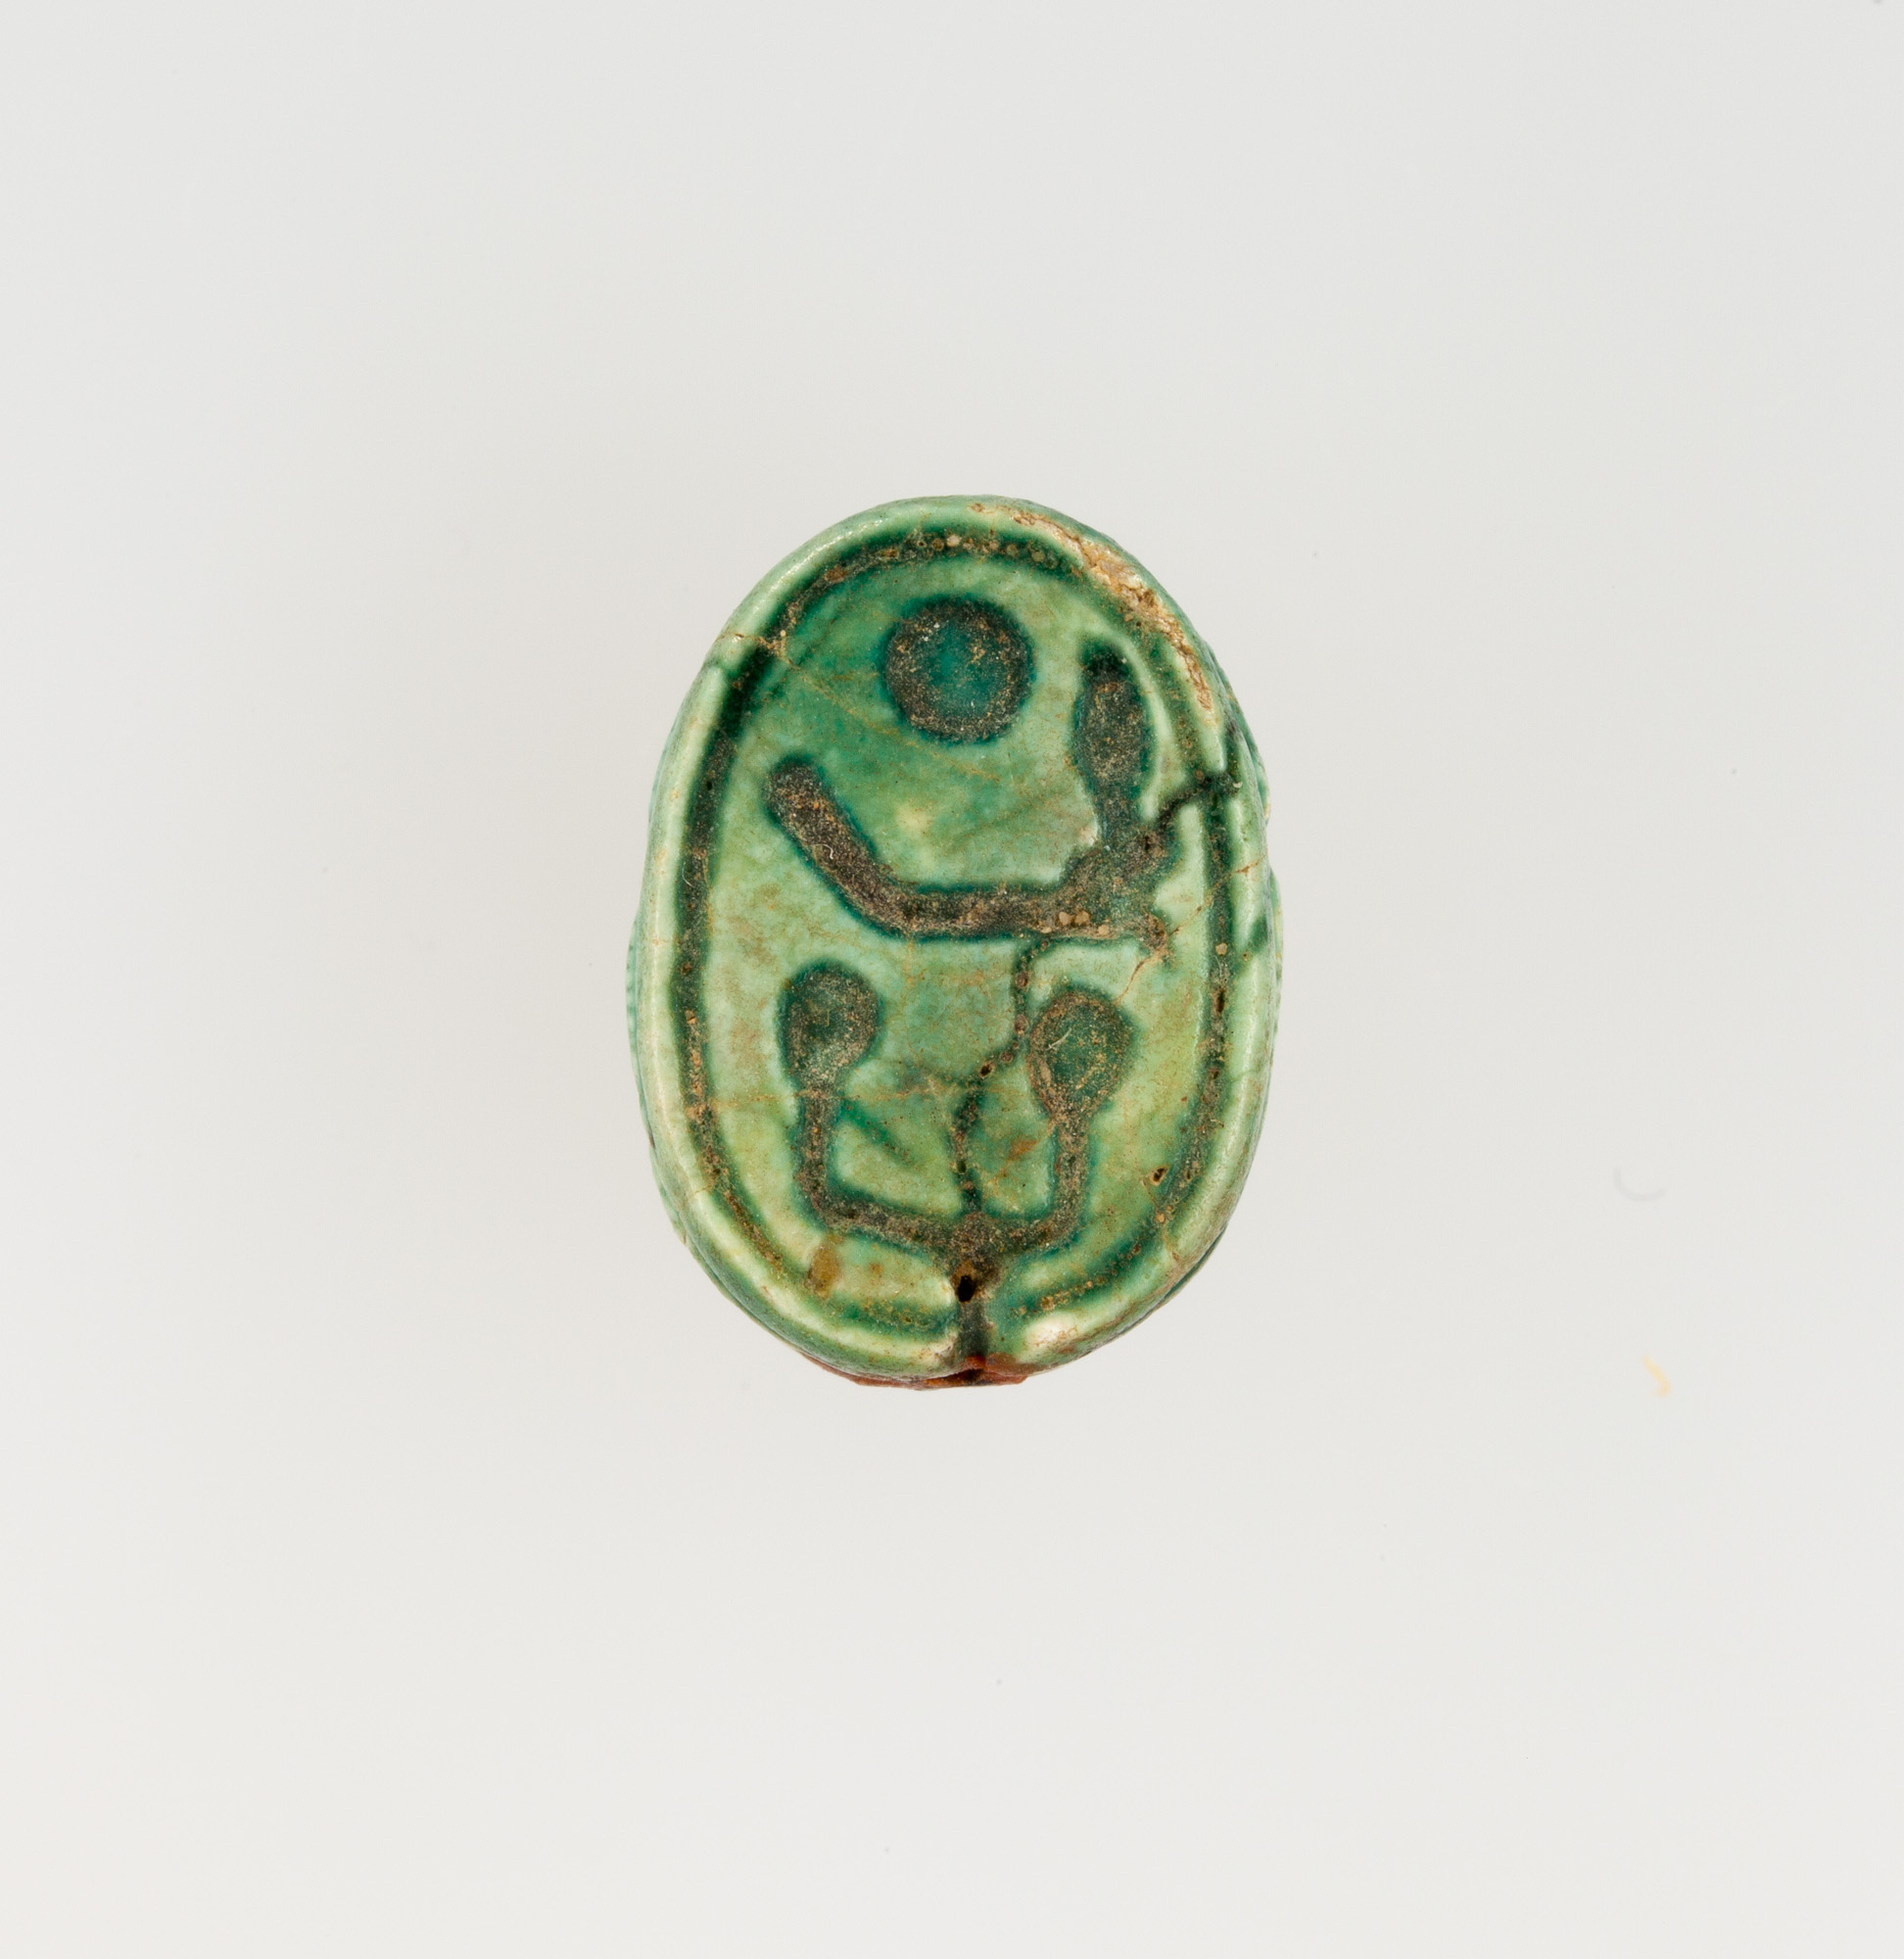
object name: scarab, amenhotep i, djeserkare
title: Scarab Inscribed with the Throne Name of Amenhotep I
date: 1525-1504 BCE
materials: stone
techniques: glazing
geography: egypt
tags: hieroglyphs,scarabs